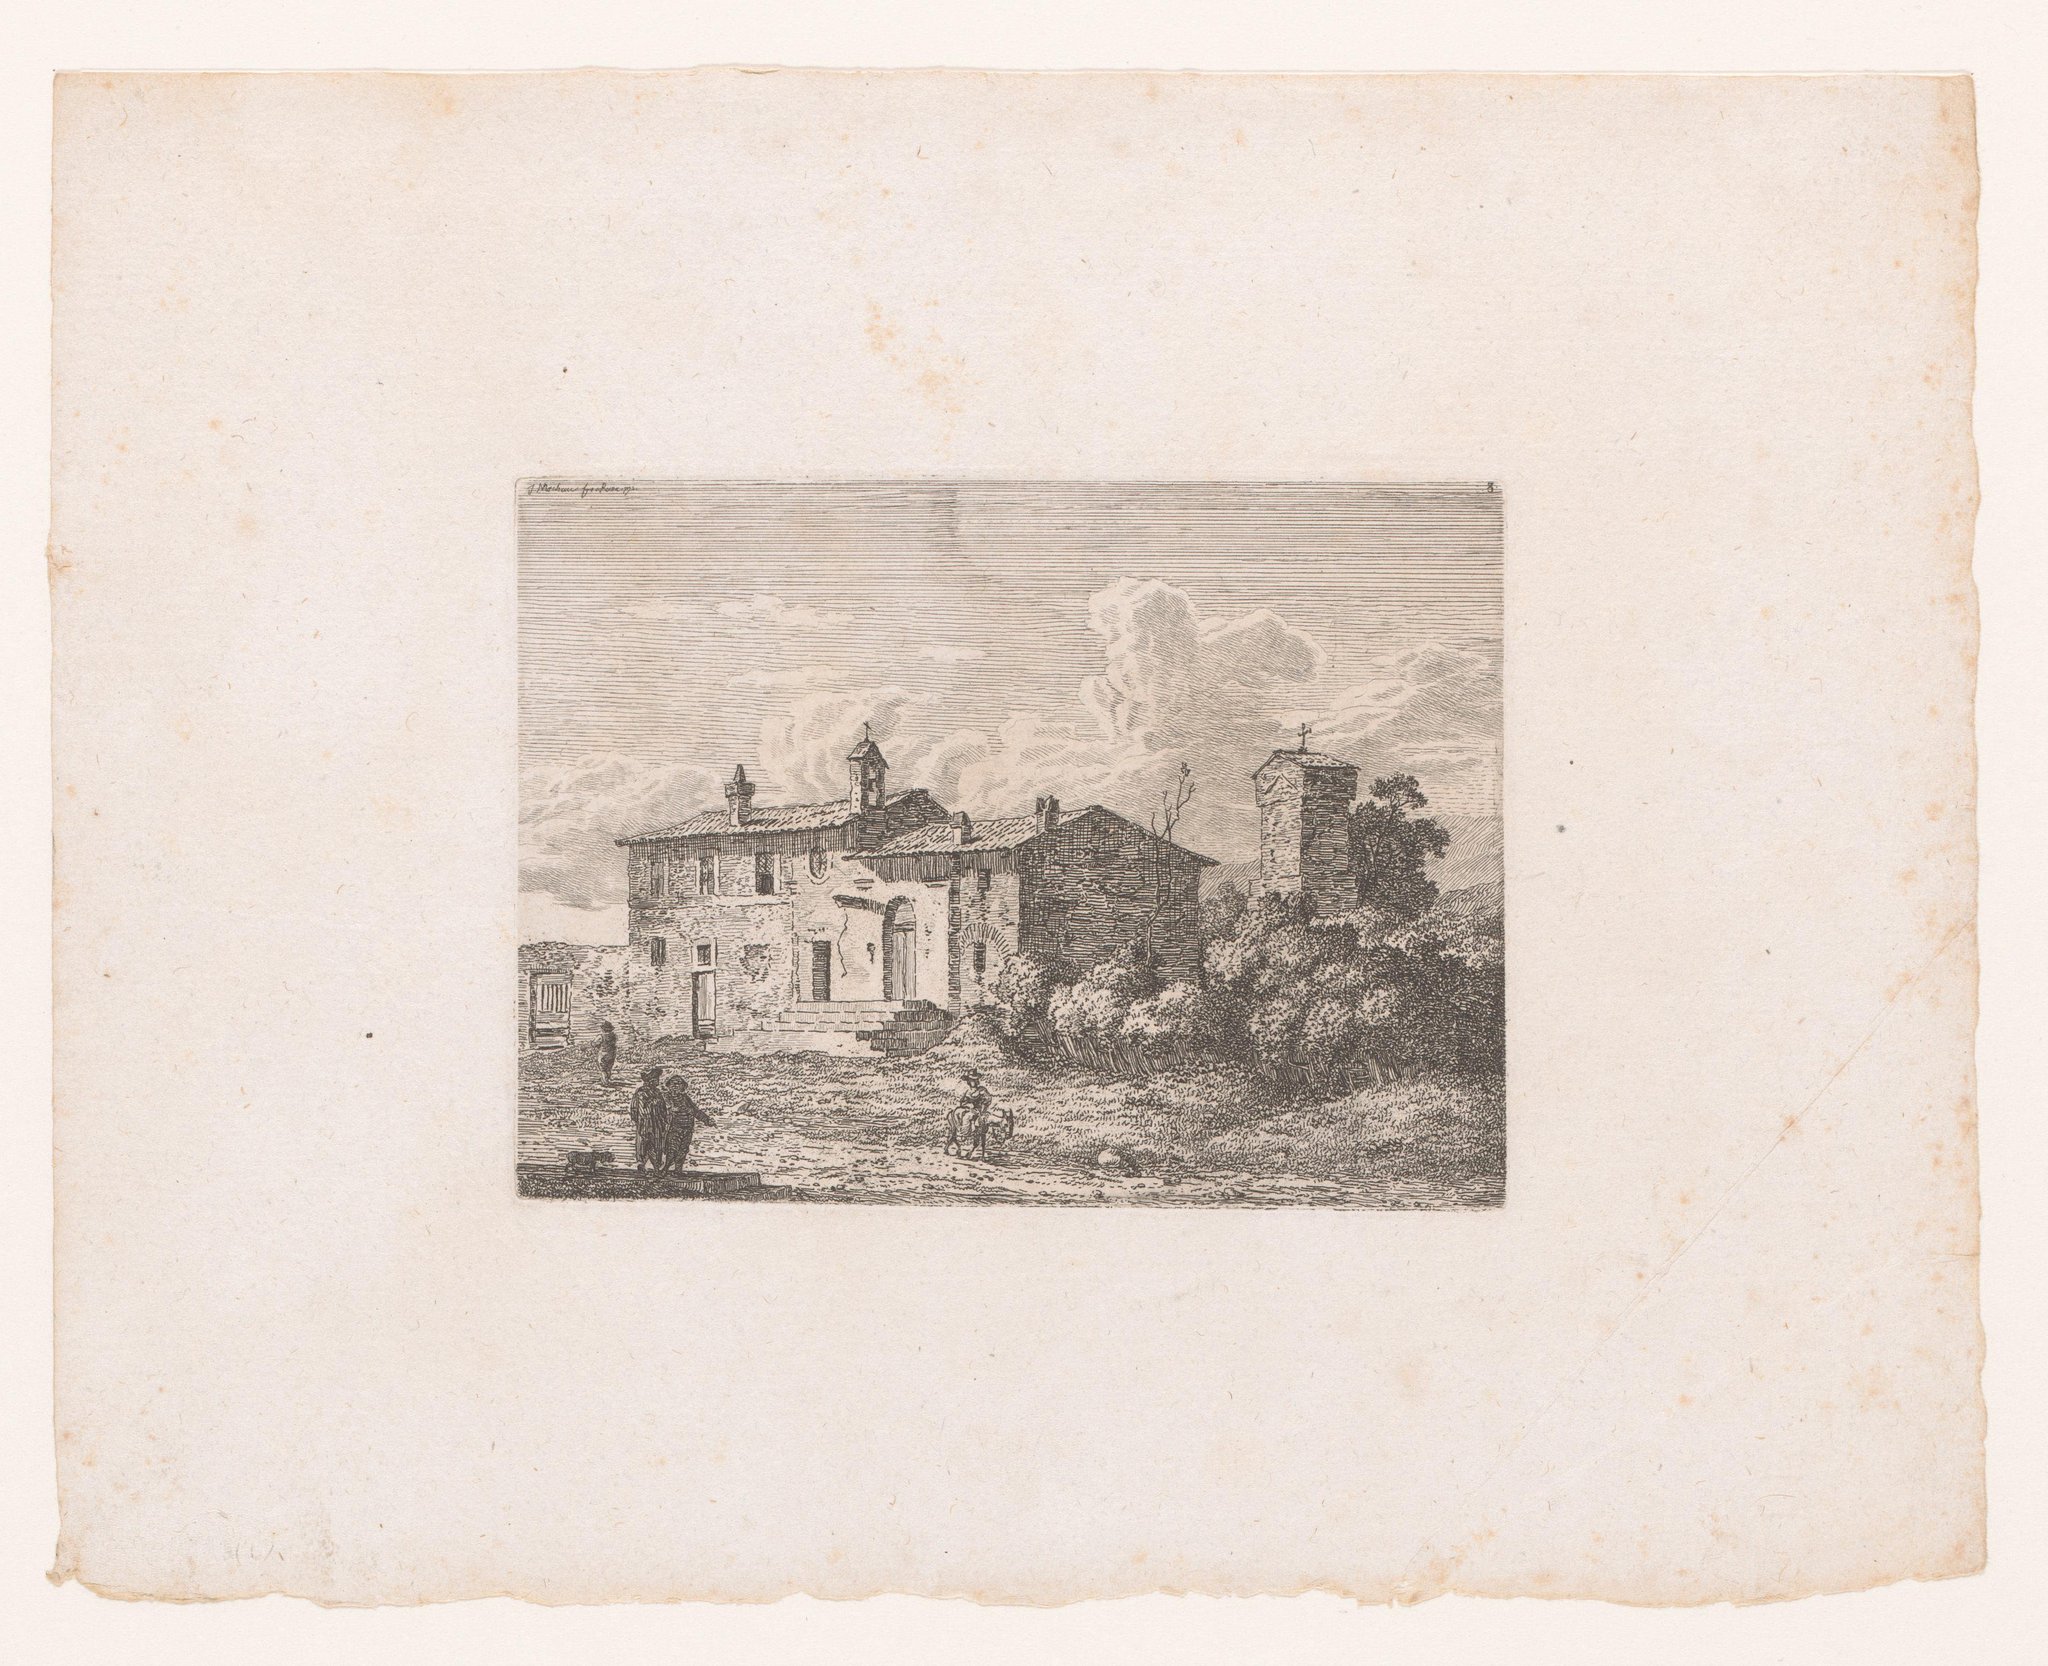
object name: print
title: Italiaans landschap met romaanse kerk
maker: jacob wilhelm mechau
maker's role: print maker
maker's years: 1745-1808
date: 1792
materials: paper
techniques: etching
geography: rome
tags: landscape with other man-made constructions not mentioned above, e.g.: graveyards, playgrounds, etc., church (exterior) - qq - small church, chapel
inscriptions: collector's mark: Lugt 2228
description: Italiaans landschap met romaanse kerk waarvoor enkele figuren.